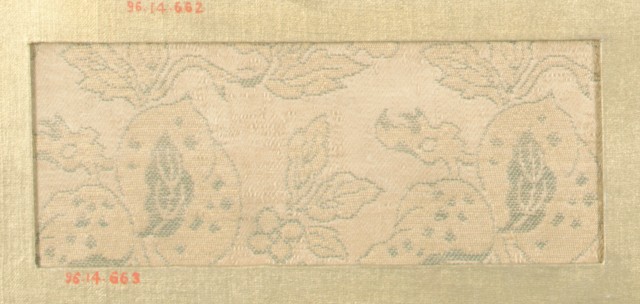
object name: piece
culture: japanese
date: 1701-1900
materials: silk